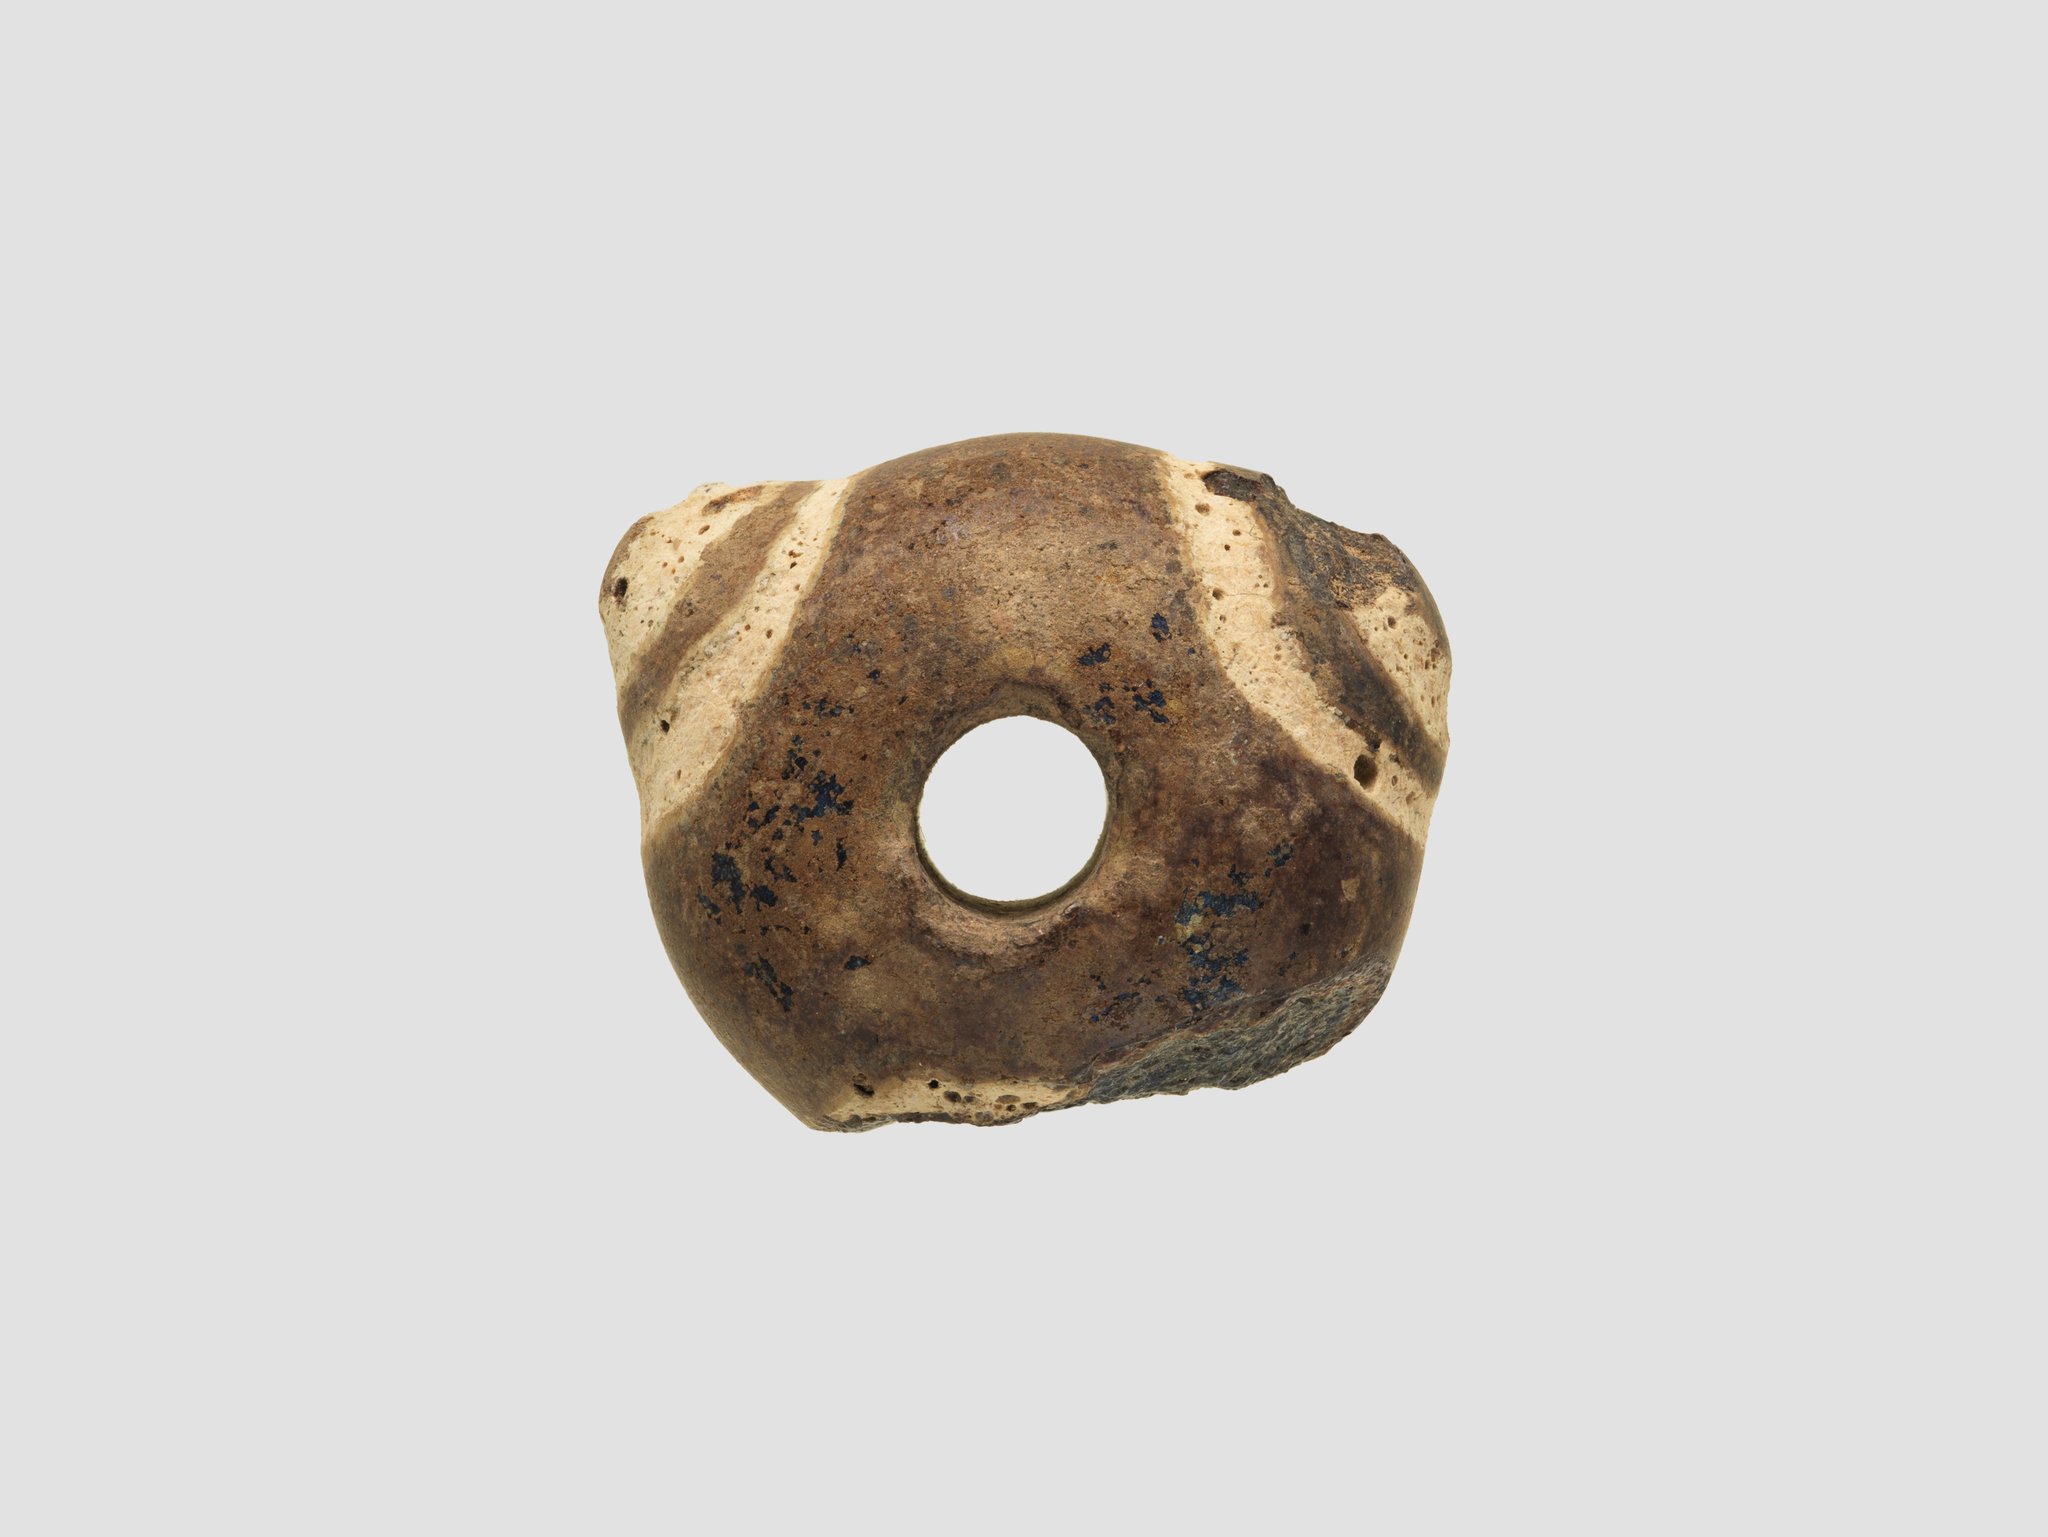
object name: bead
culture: iranian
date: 900-801 BCE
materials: glass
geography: iran